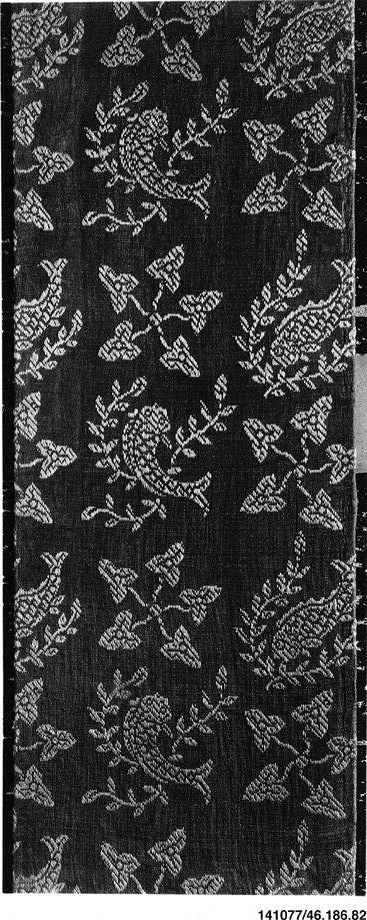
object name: sutra cover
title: Sutra Cover with Clouds and Dragons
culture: chinese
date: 1501-1600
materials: silk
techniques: patterning, weave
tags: flowers